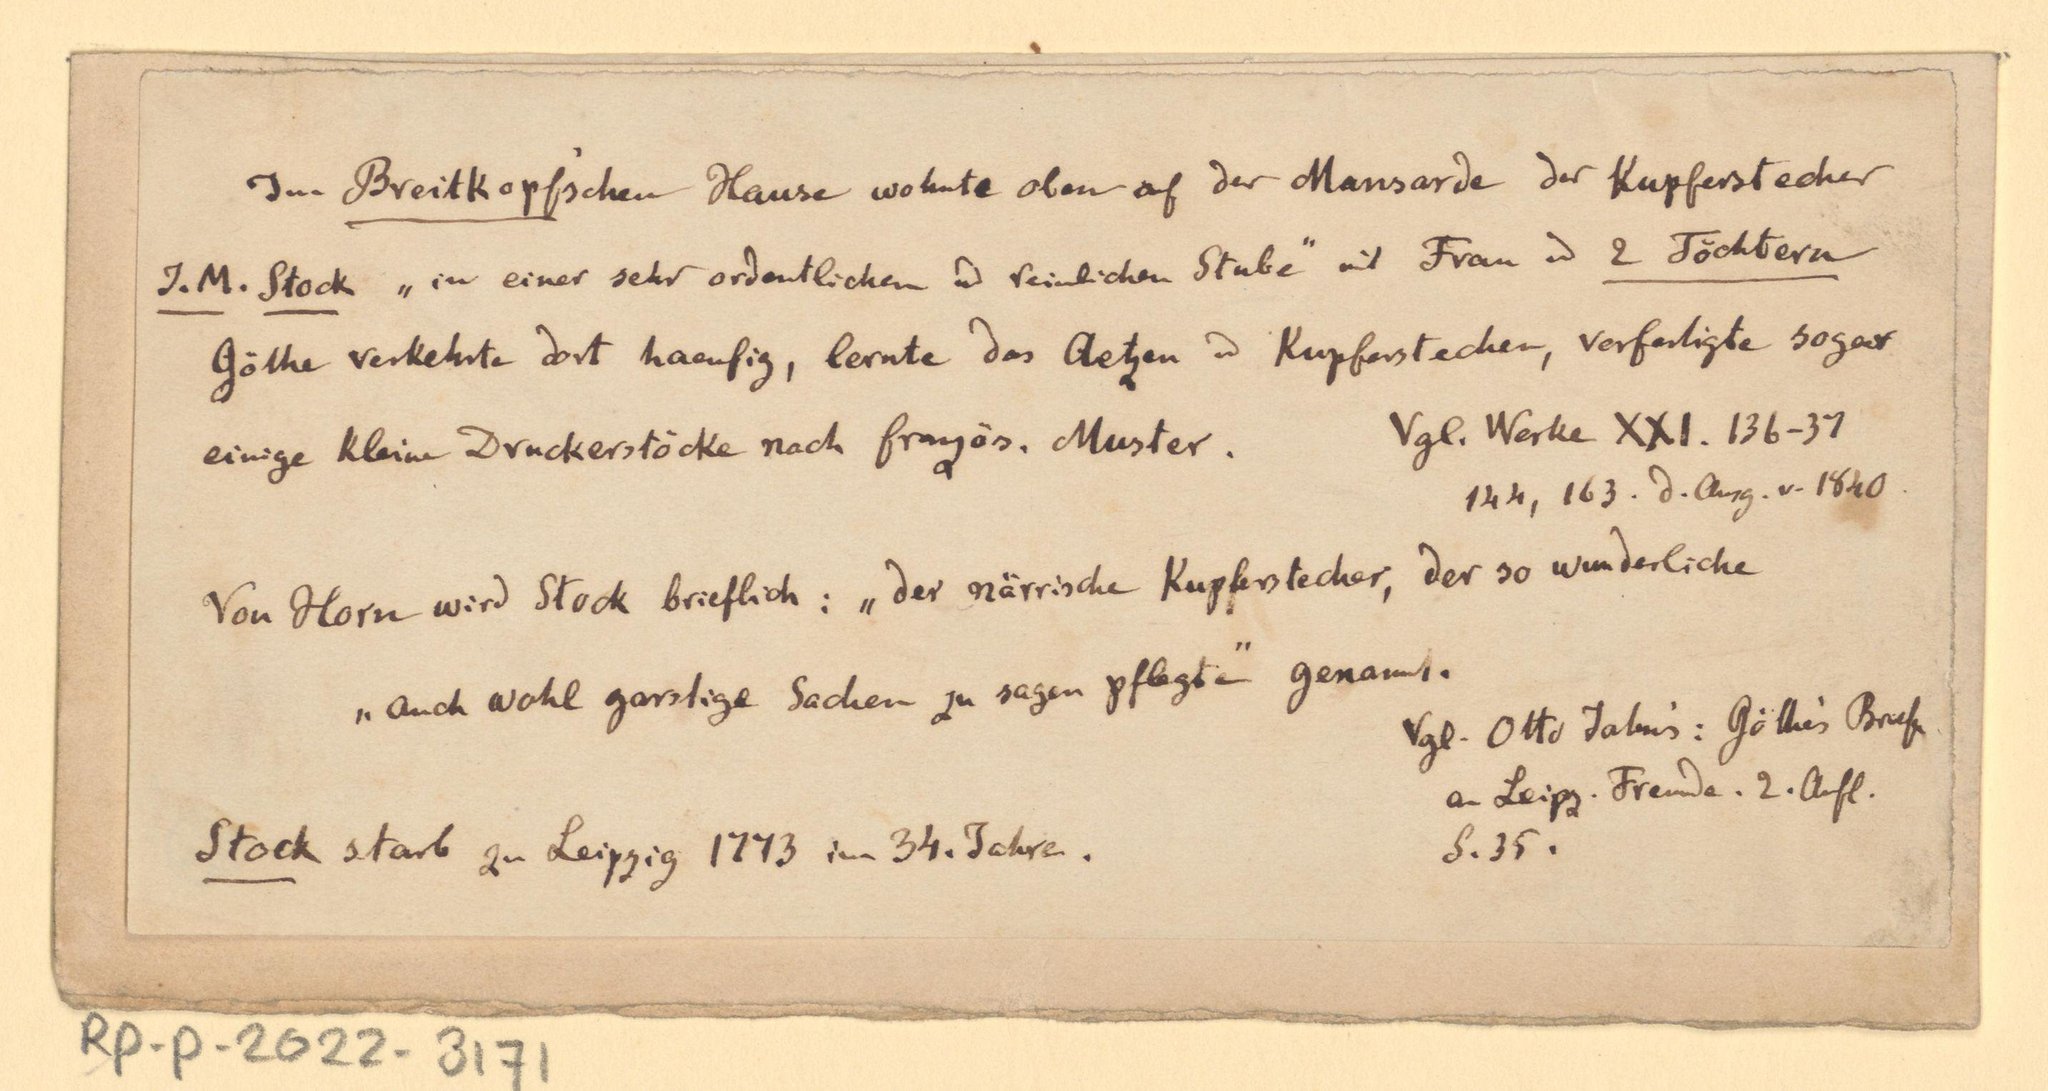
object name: print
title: Biografie van Johann Michael Stock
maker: Anonymous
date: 1773-1799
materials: ink, paper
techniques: pen, snipping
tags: print maker, johann michael stock, historical persons, graphic artist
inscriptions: inscription: ‘Im Breitkopfschen Hause (...) Aufl. / S.35.’, collector's mark: Lugt 1337